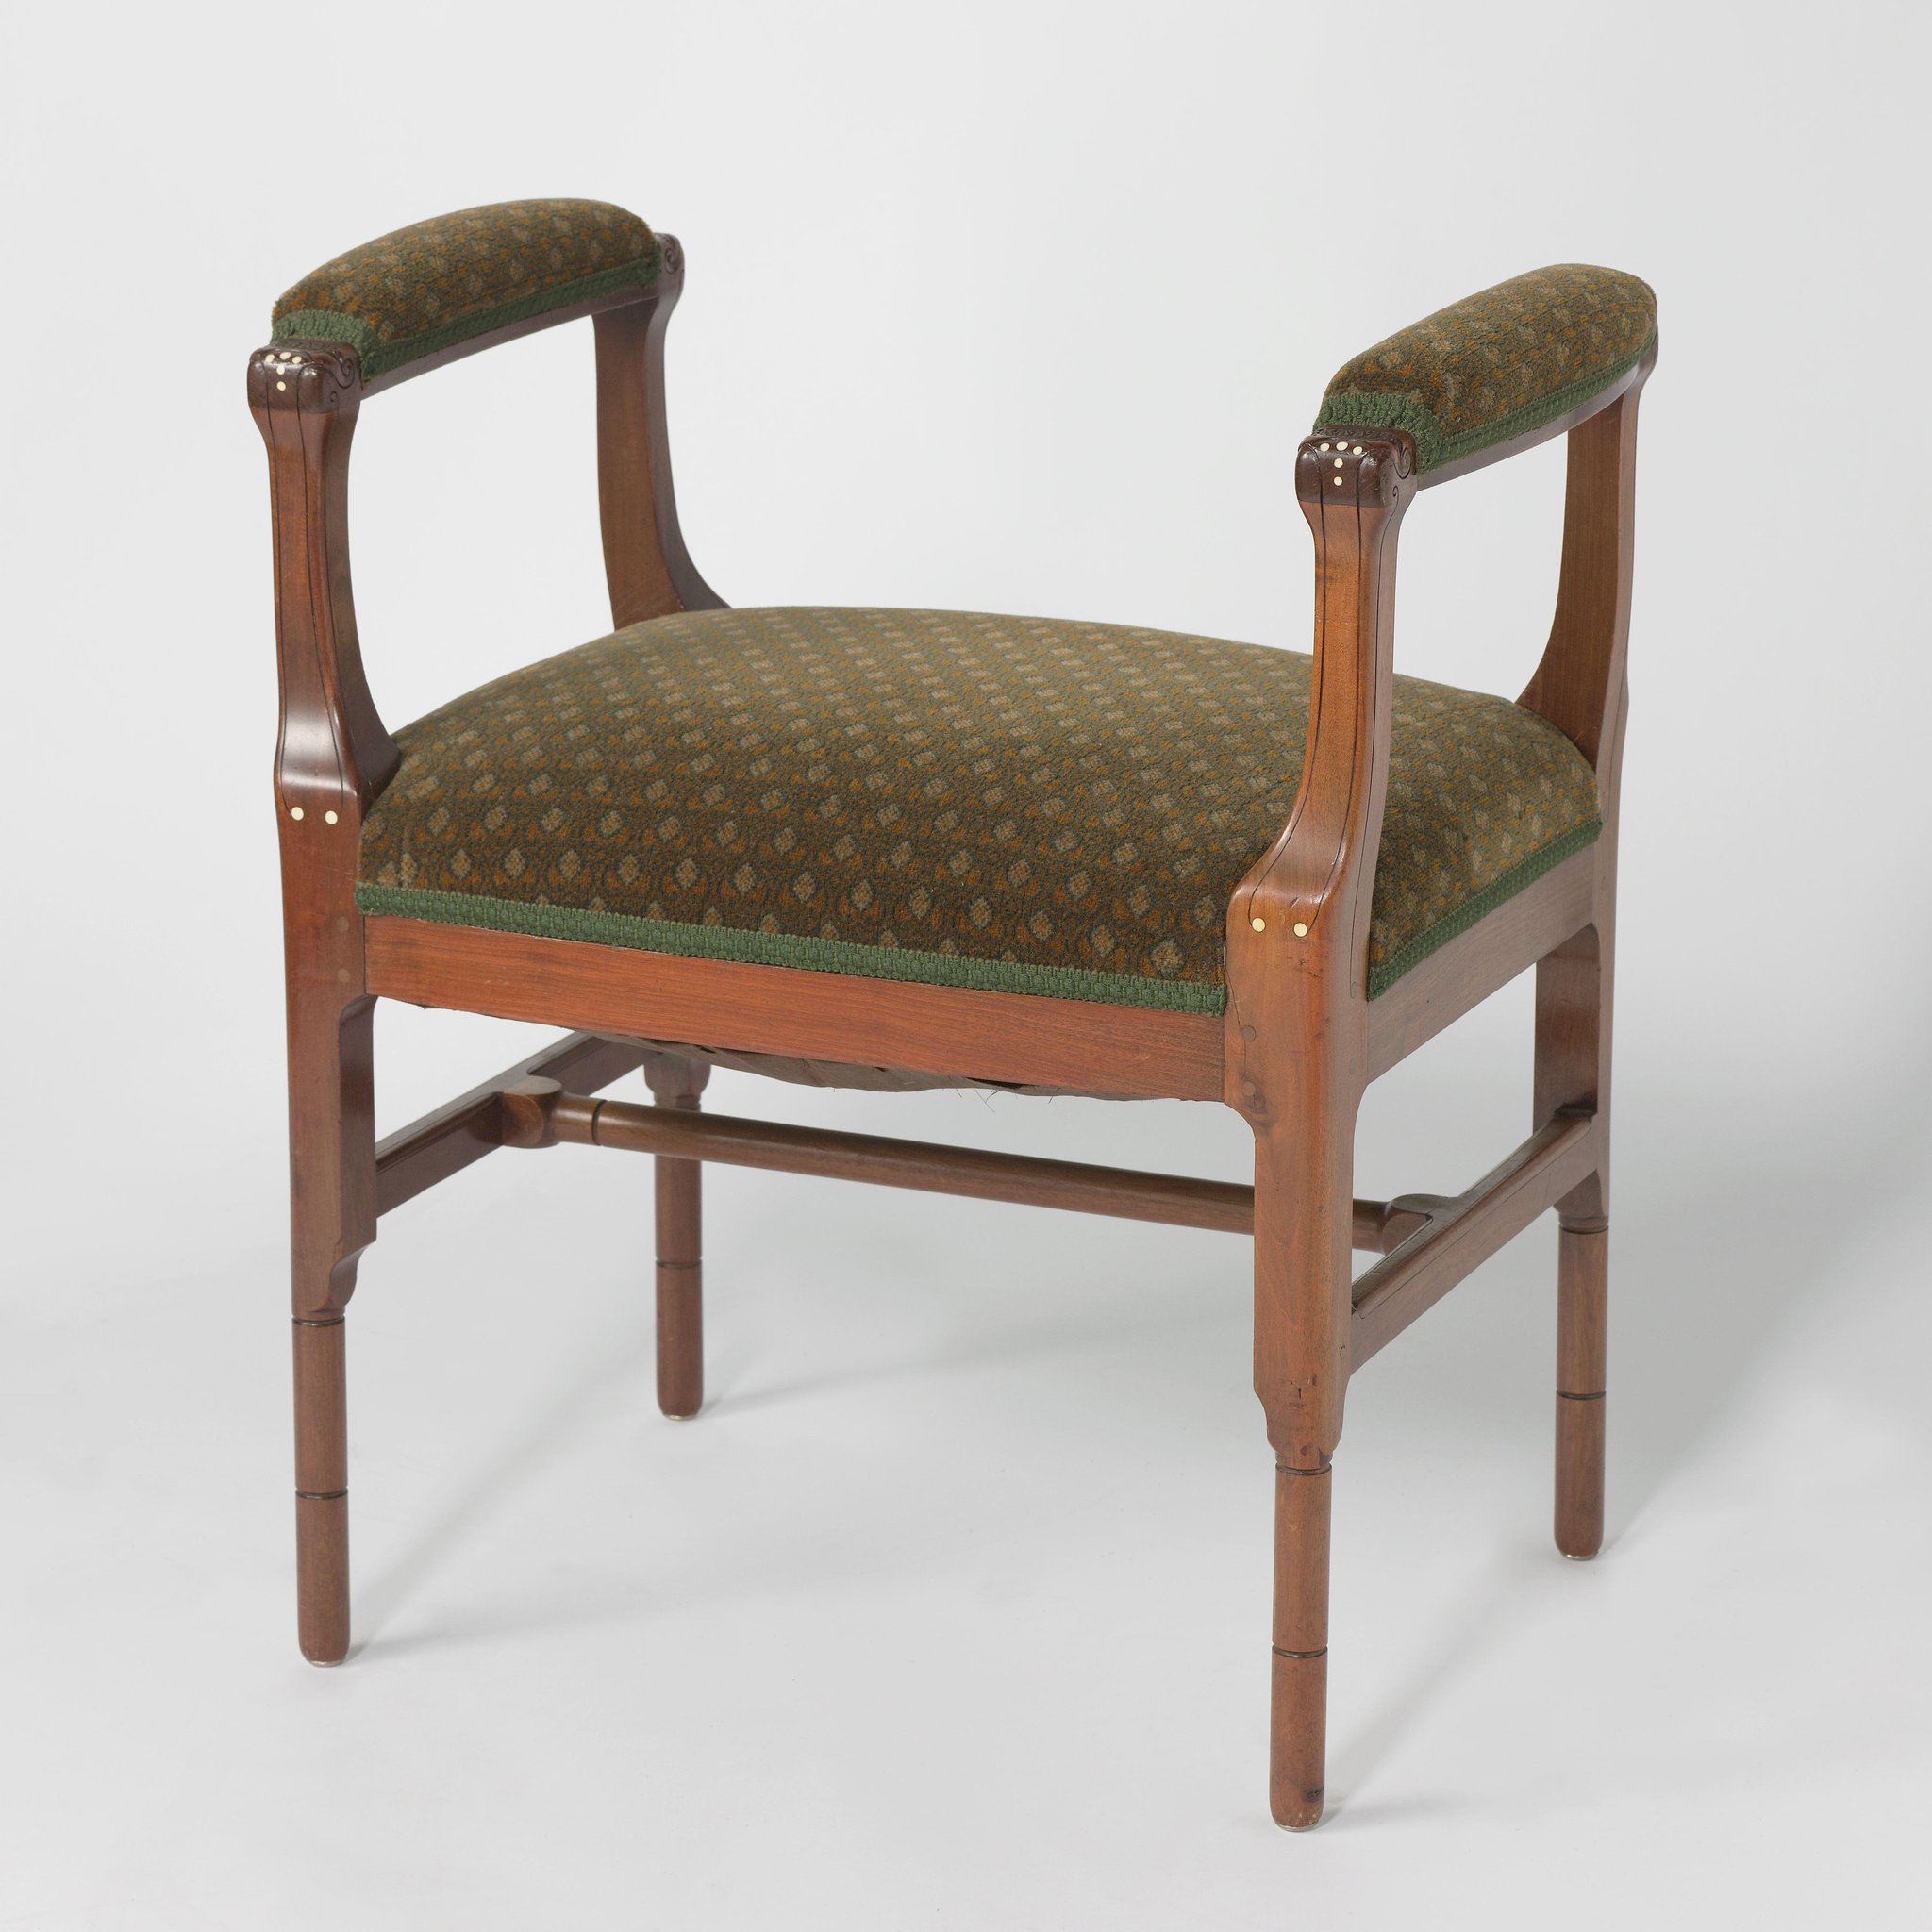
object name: sofa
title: Bank bekleed met fluweel waarop ruitmotief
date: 1905-1910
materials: ivory, wood, velvet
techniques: upholstery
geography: amsterdam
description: Bankje met twee leuningen van mahoniehout rustend op vier hoge poten die ter hoogte van het midden breed uitlopen in de hoekstijlen vanwaar deze vernauwend doorlopen in de armstutten. De vierkante hoekstijlen zijn ter hoogte van het midden onderling verbonden door middel van een H-vormig kruis. Zowel de zitting als de bovenzijde van de armleggers is bekleed met fluweel in groen, beige en geel met een ruitmotief afgezet met band in donkergroen. De hoekstijlen en armstutten bevatten gesneden krommende lijnen en ingelegde cirkels van ivoor.